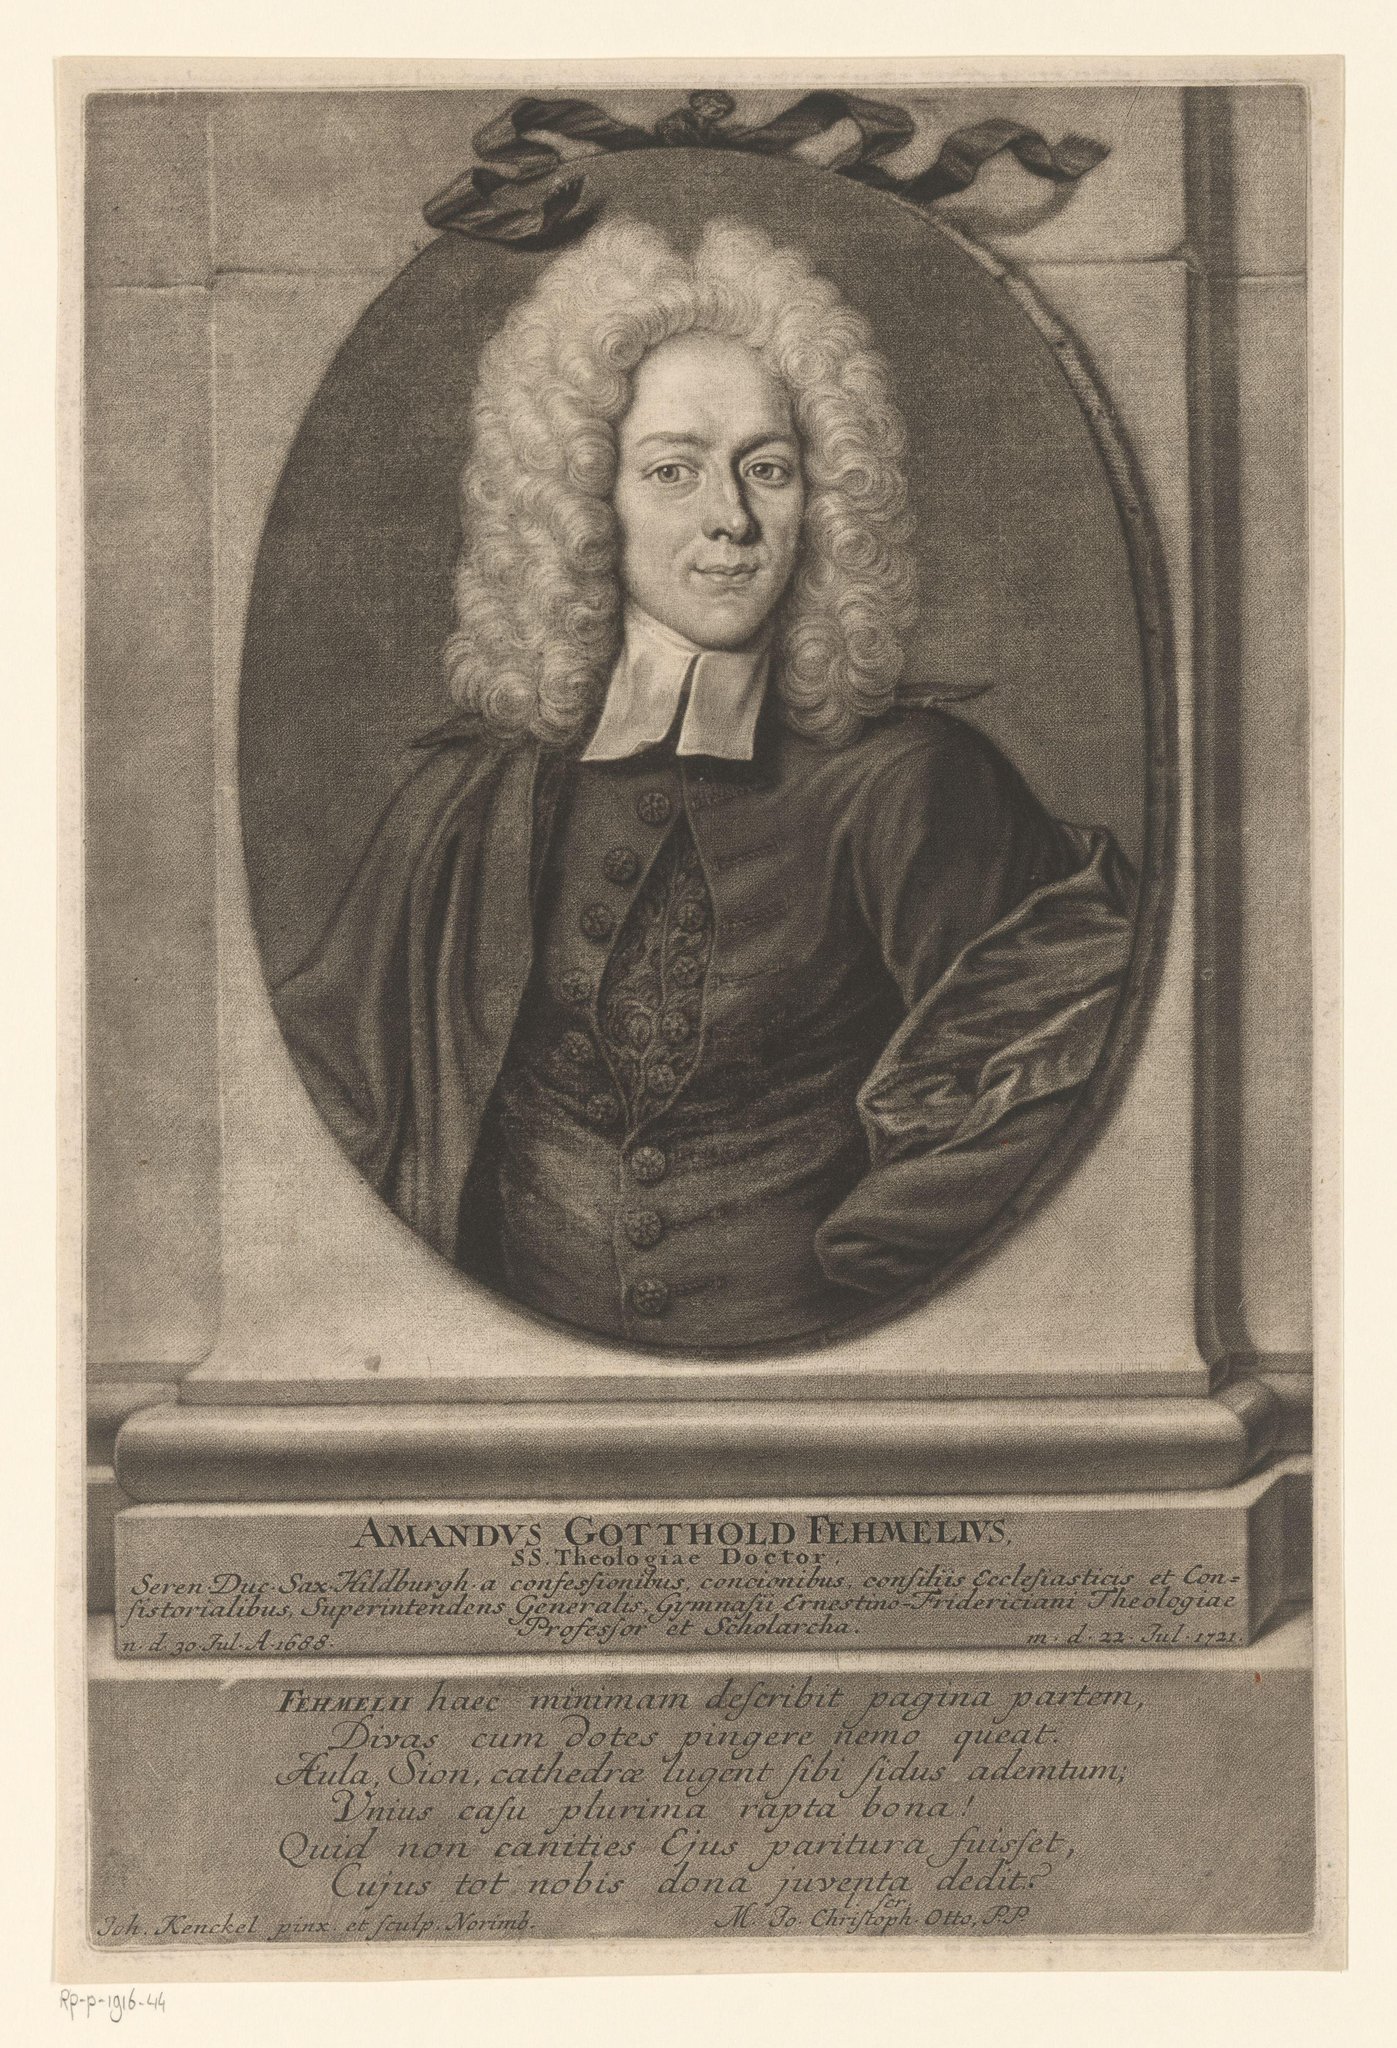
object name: print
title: Portret van Amandus Gotthold Fehmel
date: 1721-1722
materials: paper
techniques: mezzotint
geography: nuremberg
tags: ornament ~ medallion, historical persons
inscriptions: collector's mark: Lugt 2228